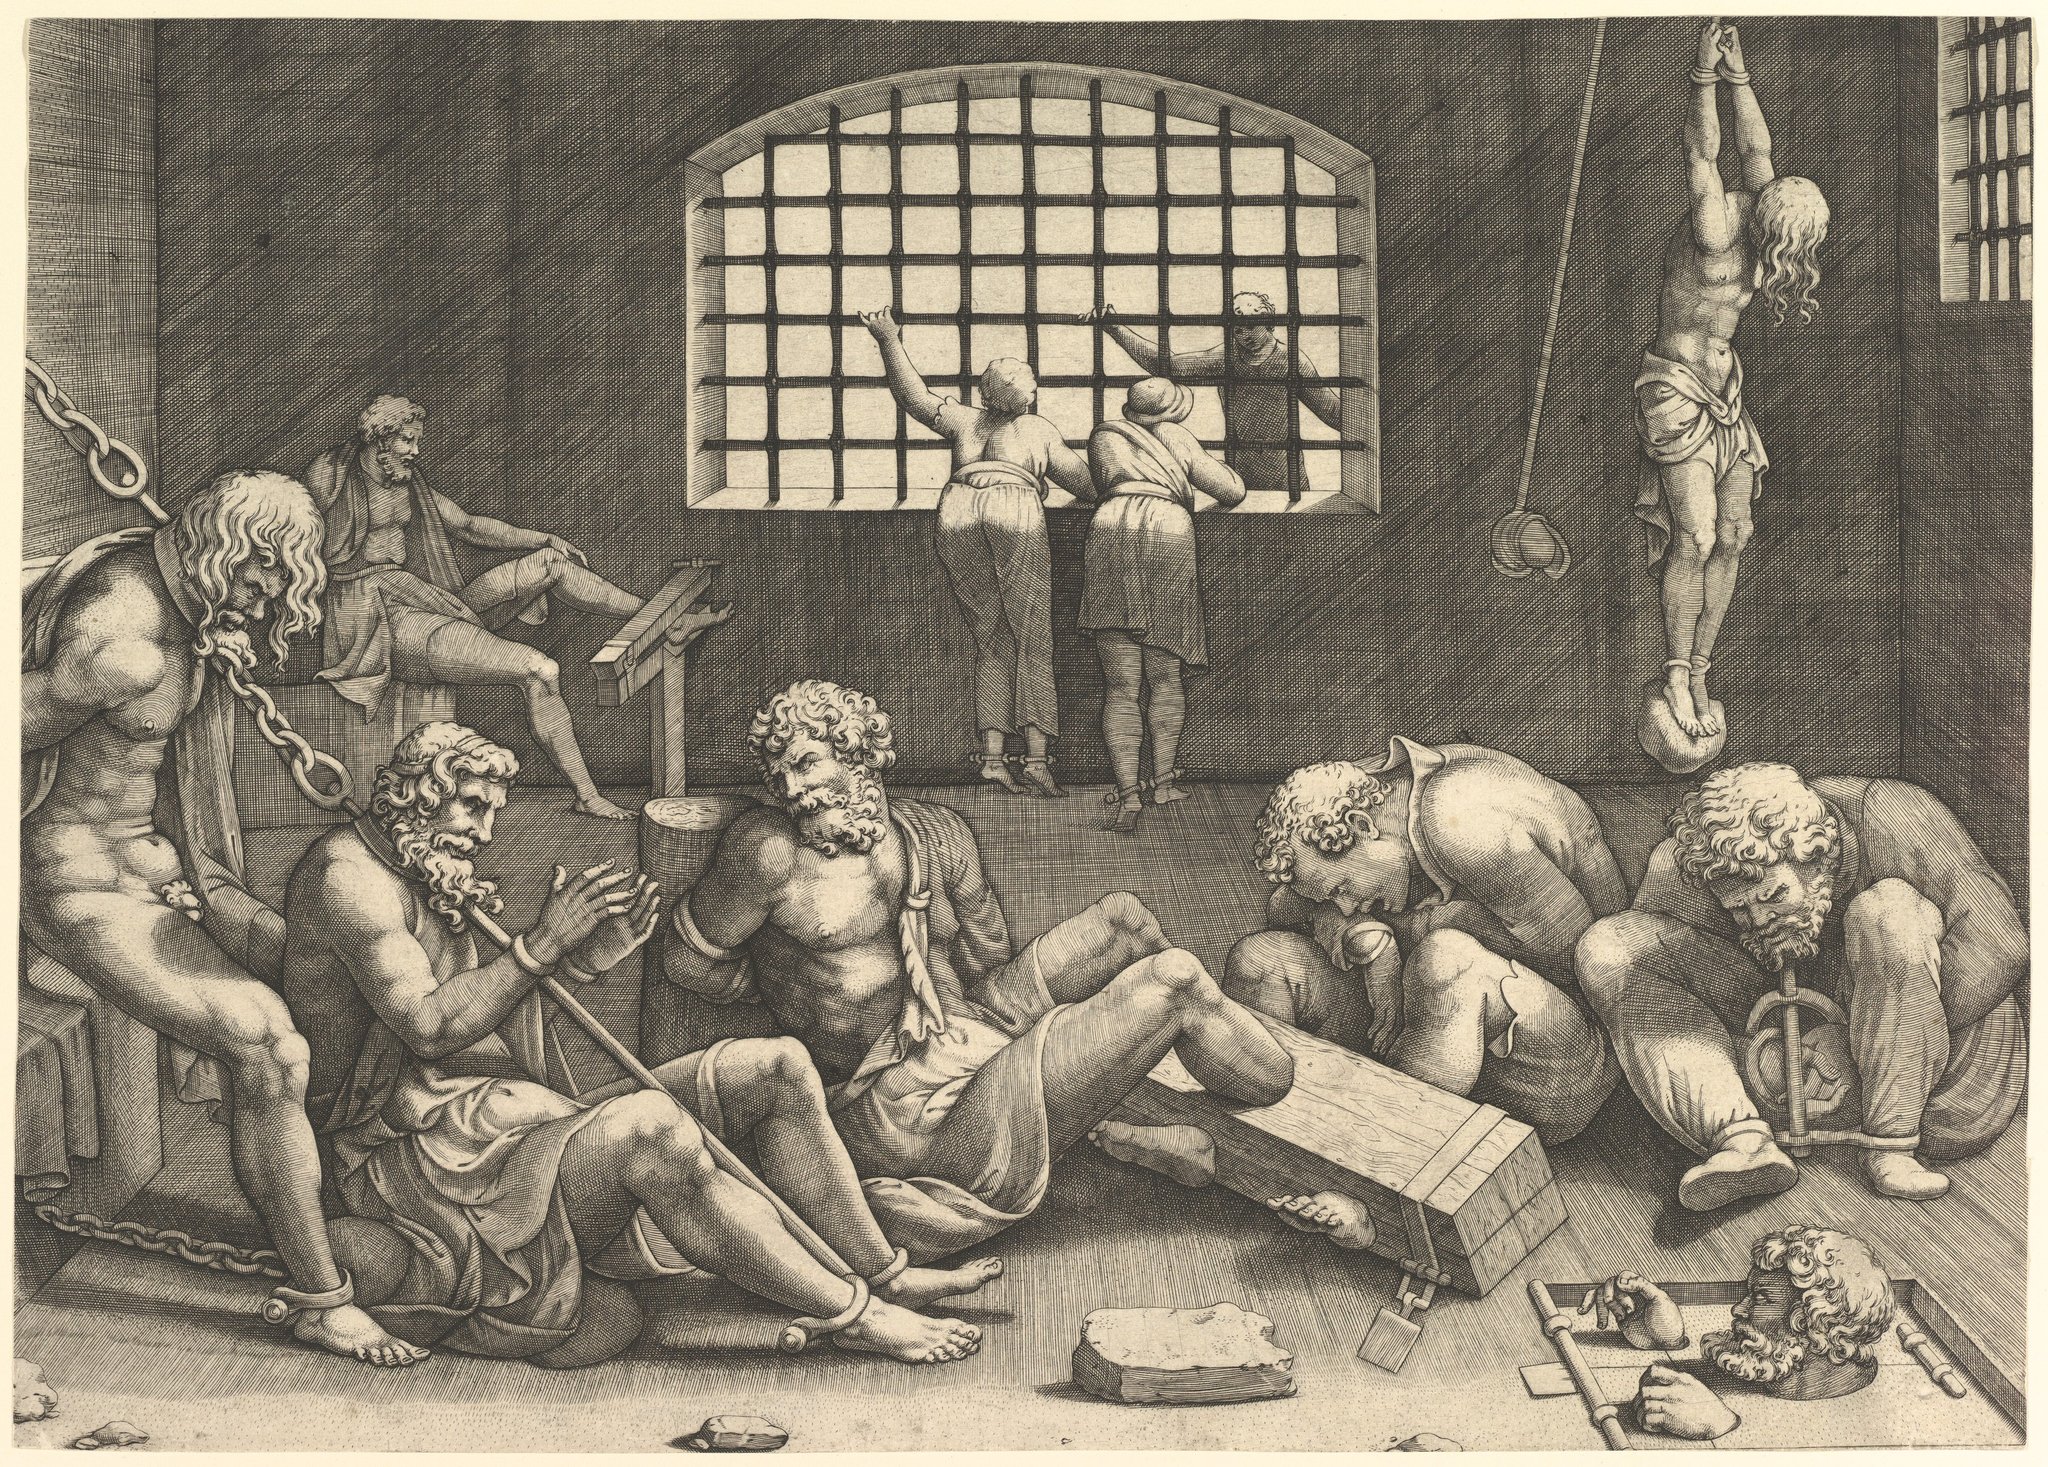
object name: print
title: The Prison; a group of men in a dungeon bound in chains and shackles; to the right a figure hanging from his arms, tied to a boulder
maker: Anonymous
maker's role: artist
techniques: engraving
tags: prisons,prisoners,suffering,men